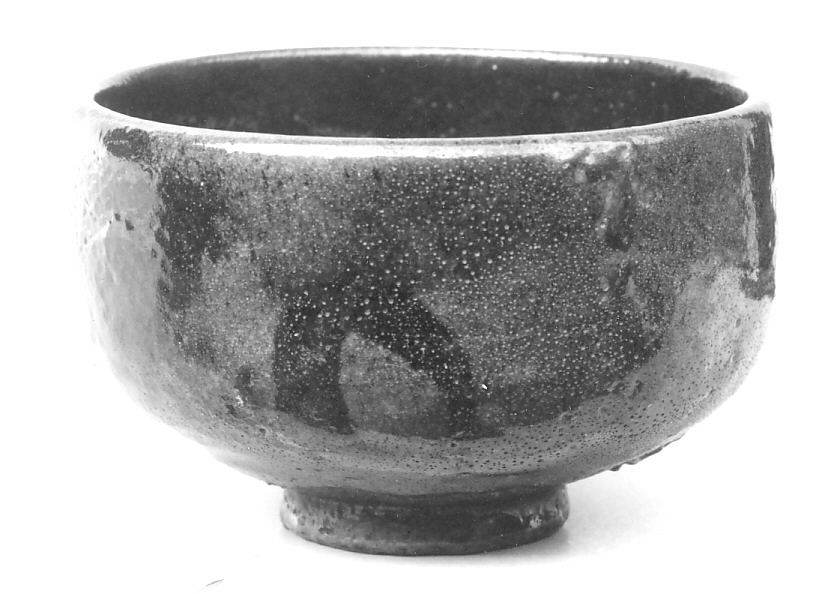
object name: teabowl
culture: japanese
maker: ryōnyu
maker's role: artist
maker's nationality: japanese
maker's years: 1735-1835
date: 1790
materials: clay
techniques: overglaze, underglaze